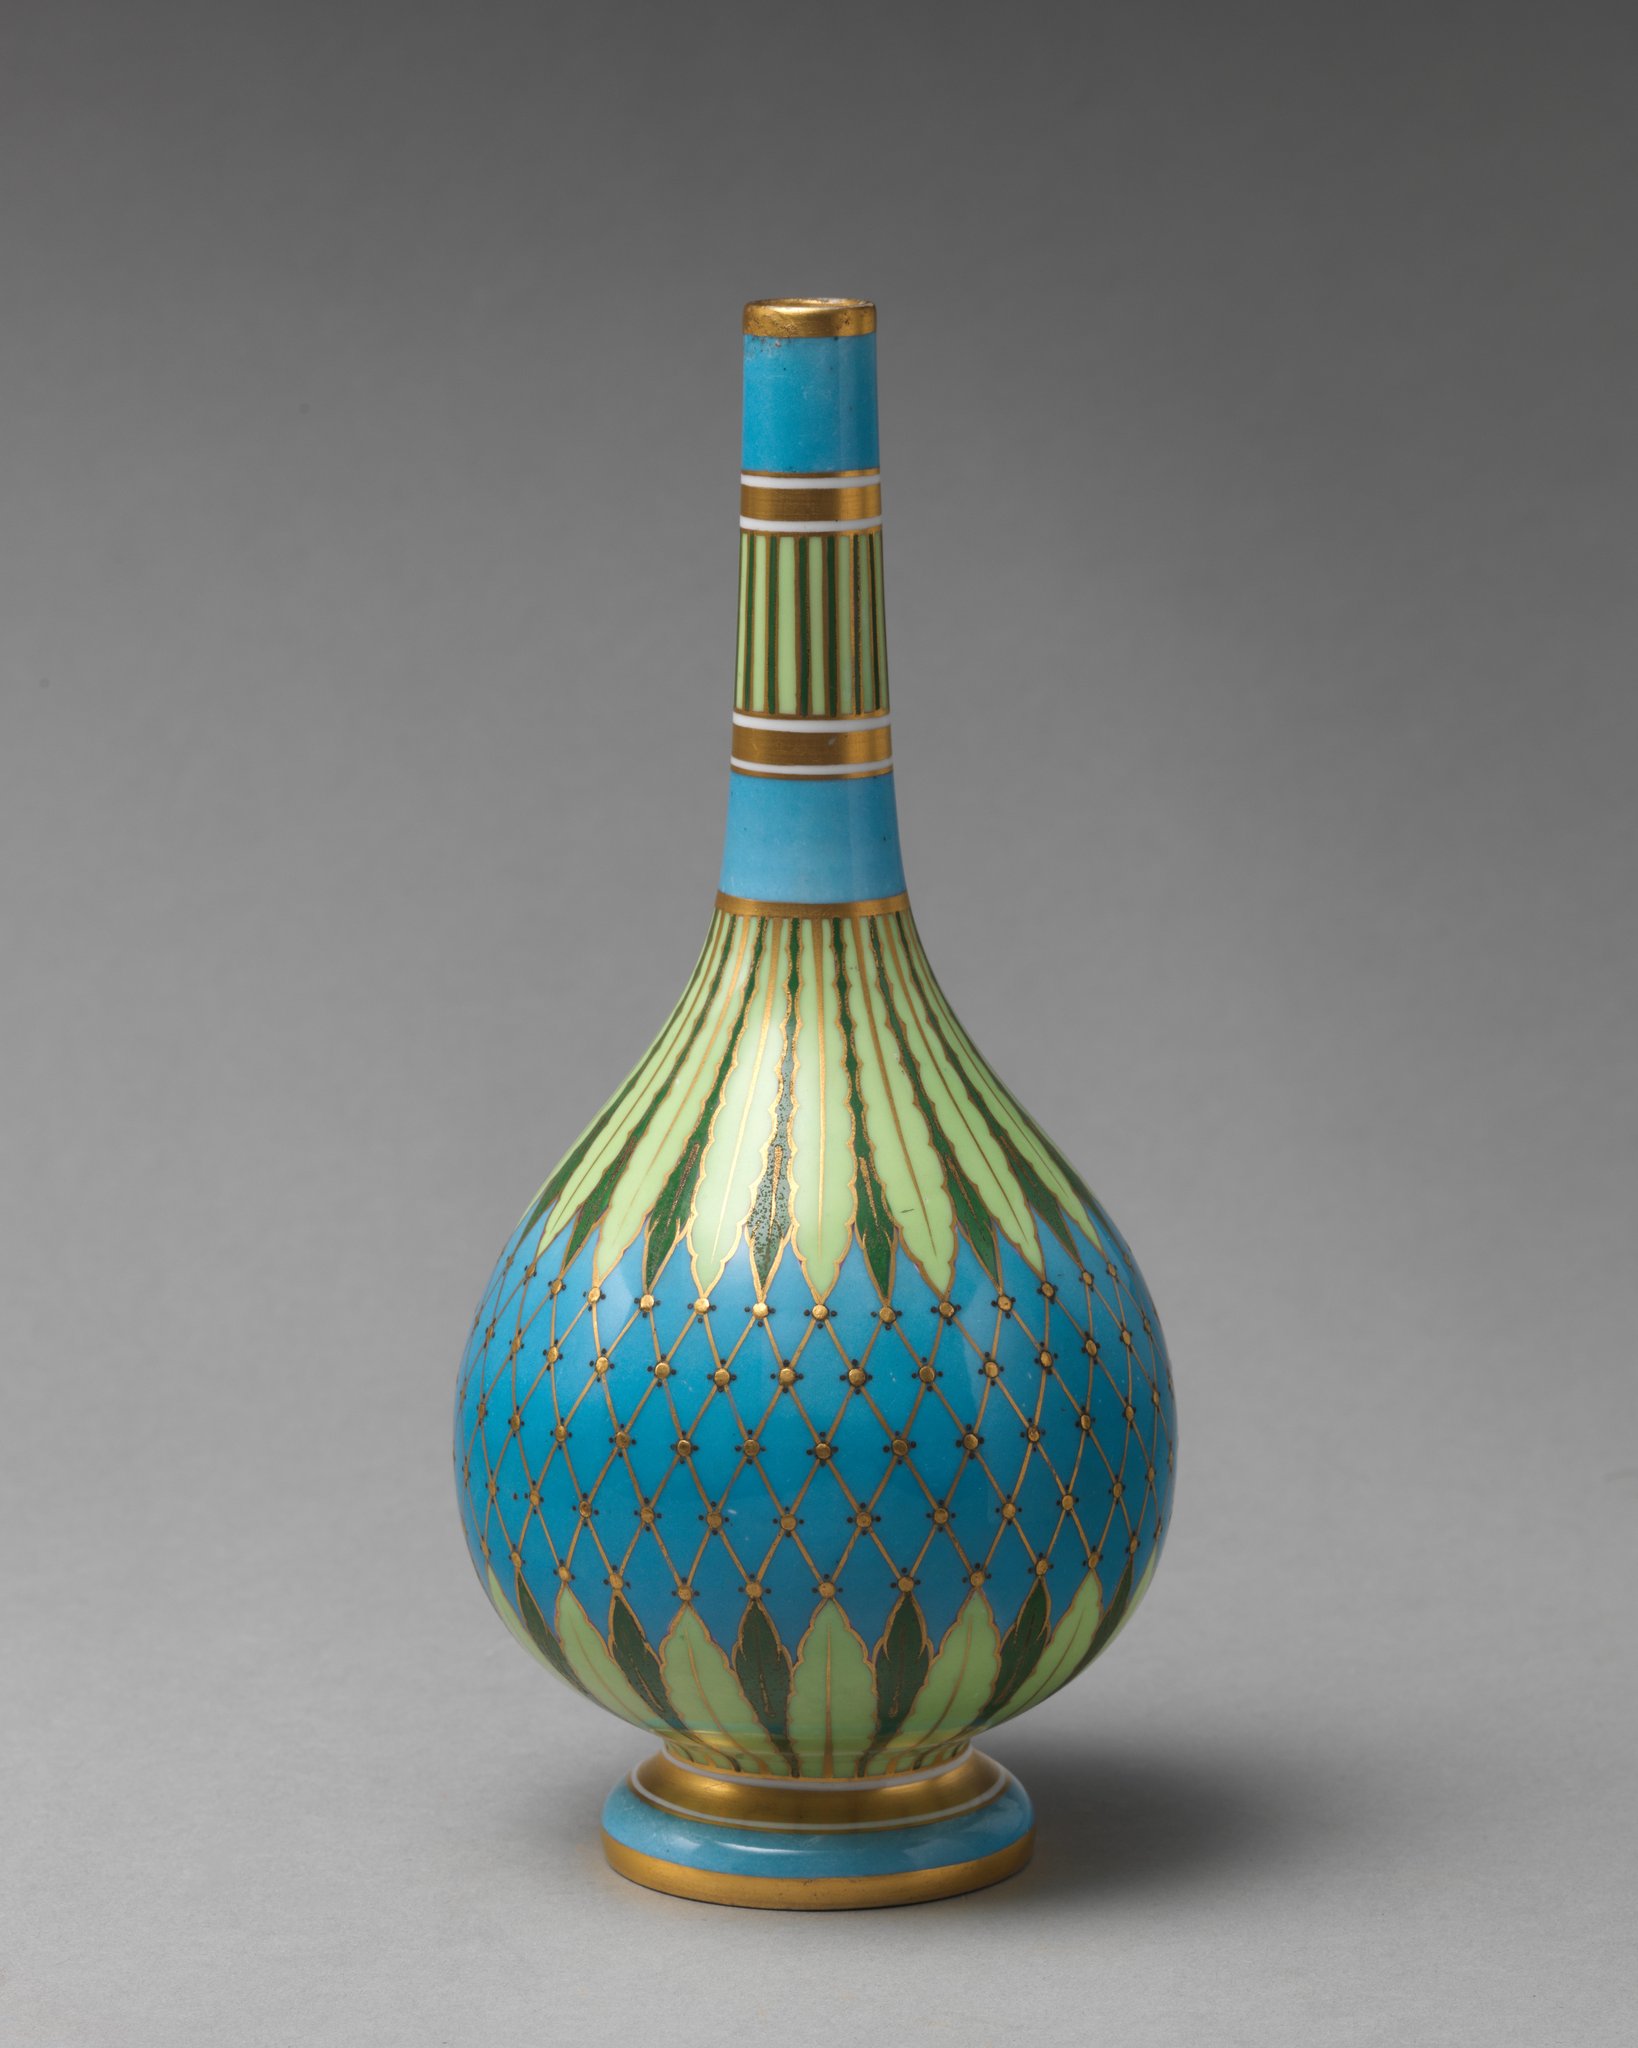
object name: bottle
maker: minton(s)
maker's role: maker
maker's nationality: british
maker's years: 1793-2001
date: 1860-1870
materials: bone china